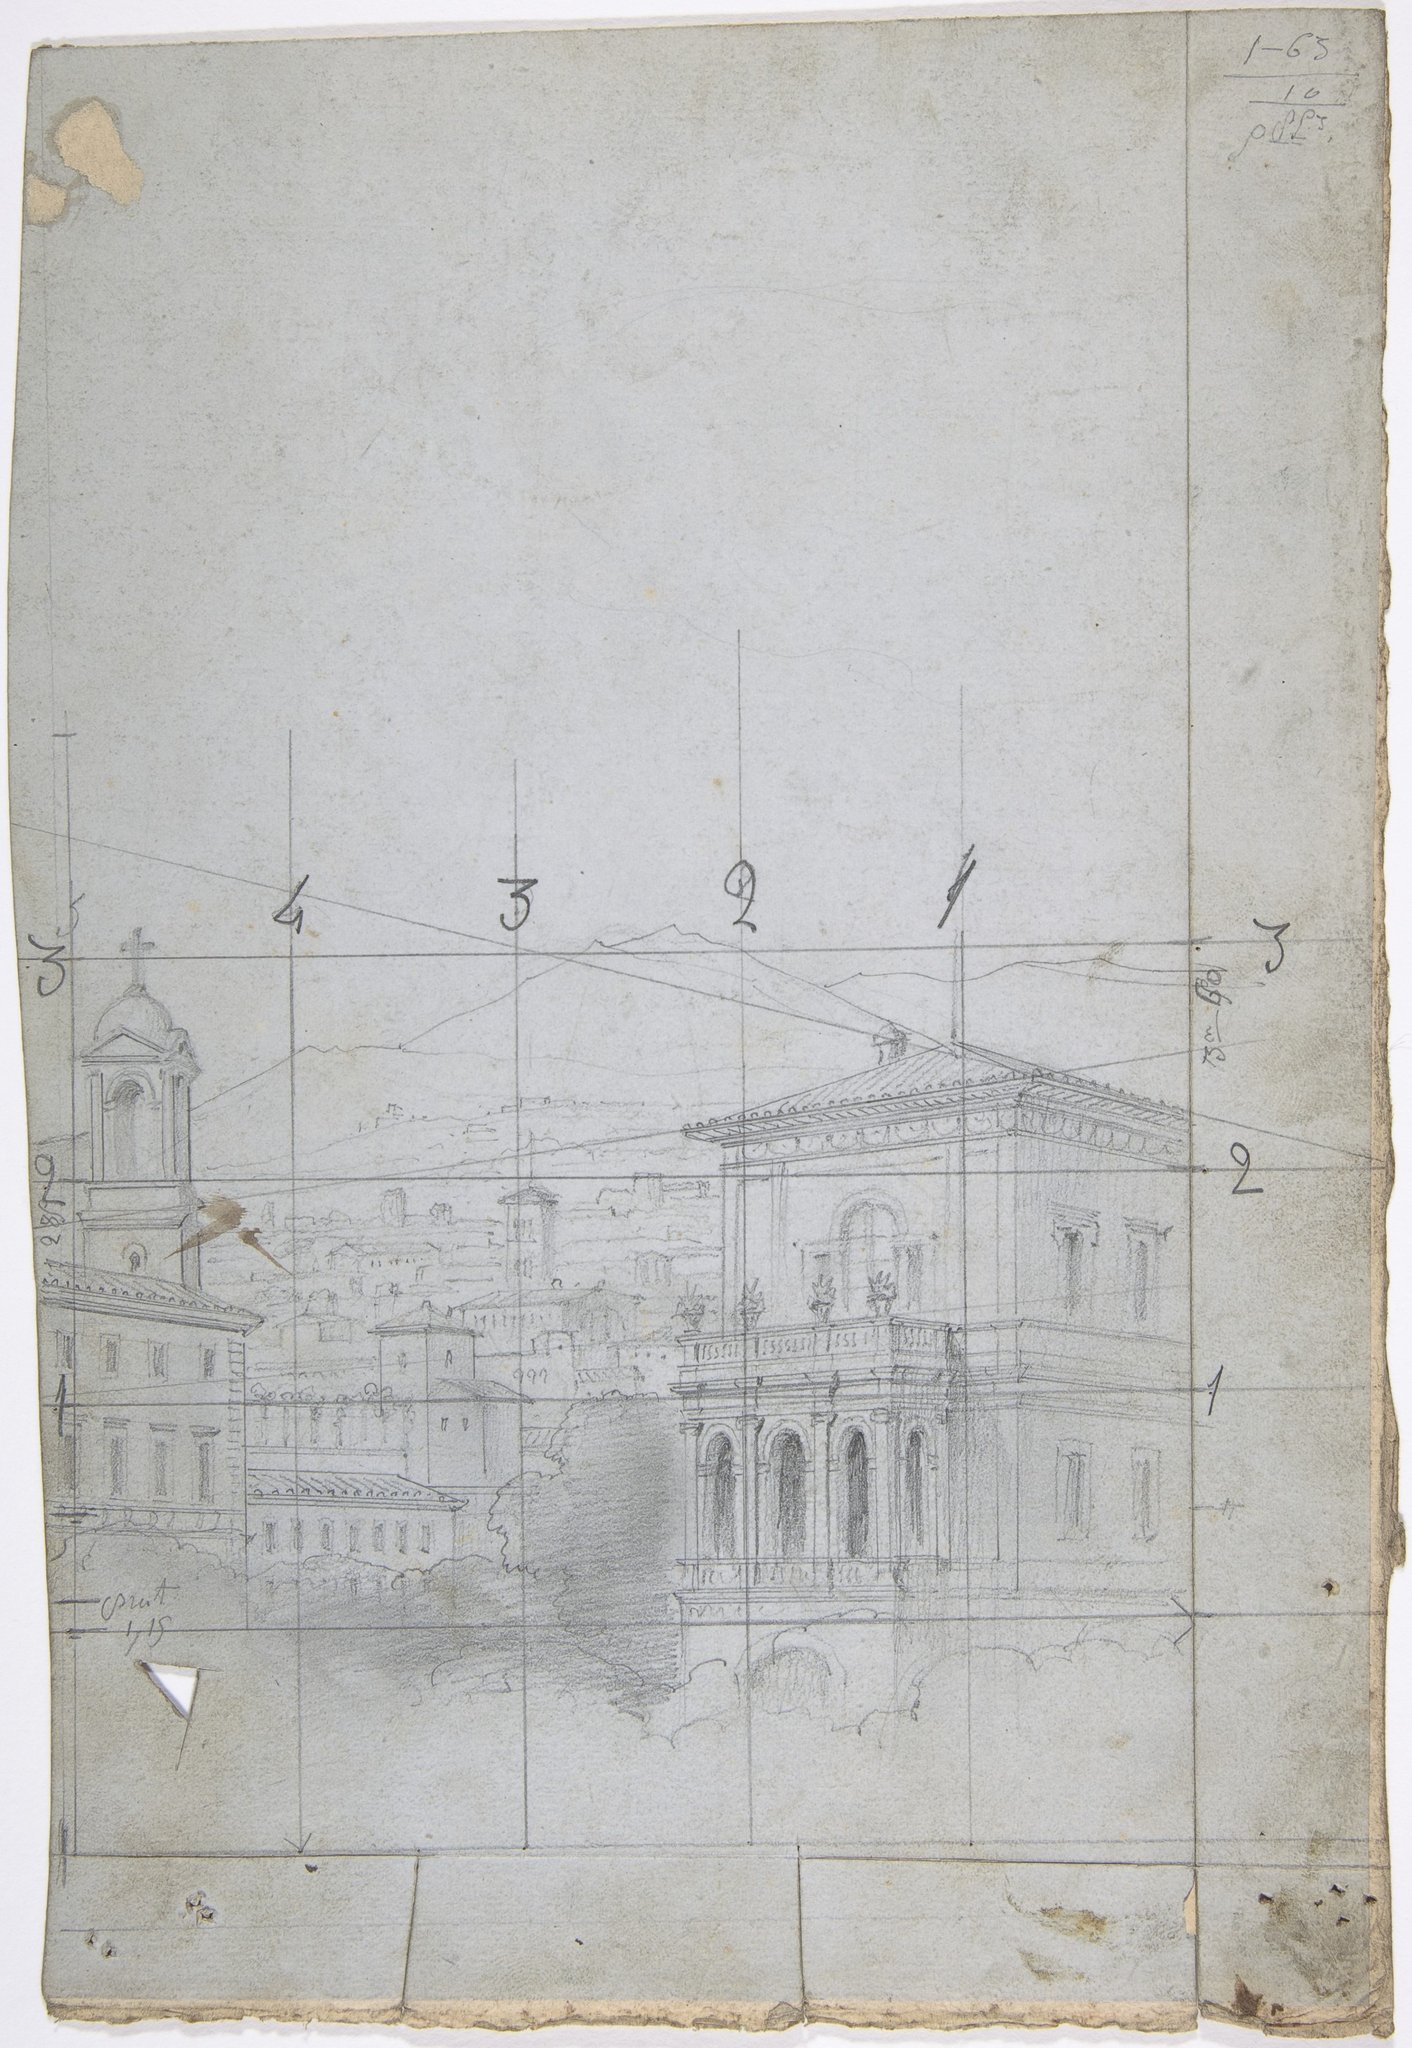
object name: drawing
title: Design for a Stage Set at the Opéra, Paris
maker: eugène cicéri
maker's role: artist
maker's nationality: french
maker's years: 1813-1890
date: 1830-1890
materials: graphite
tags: buildings,stage design